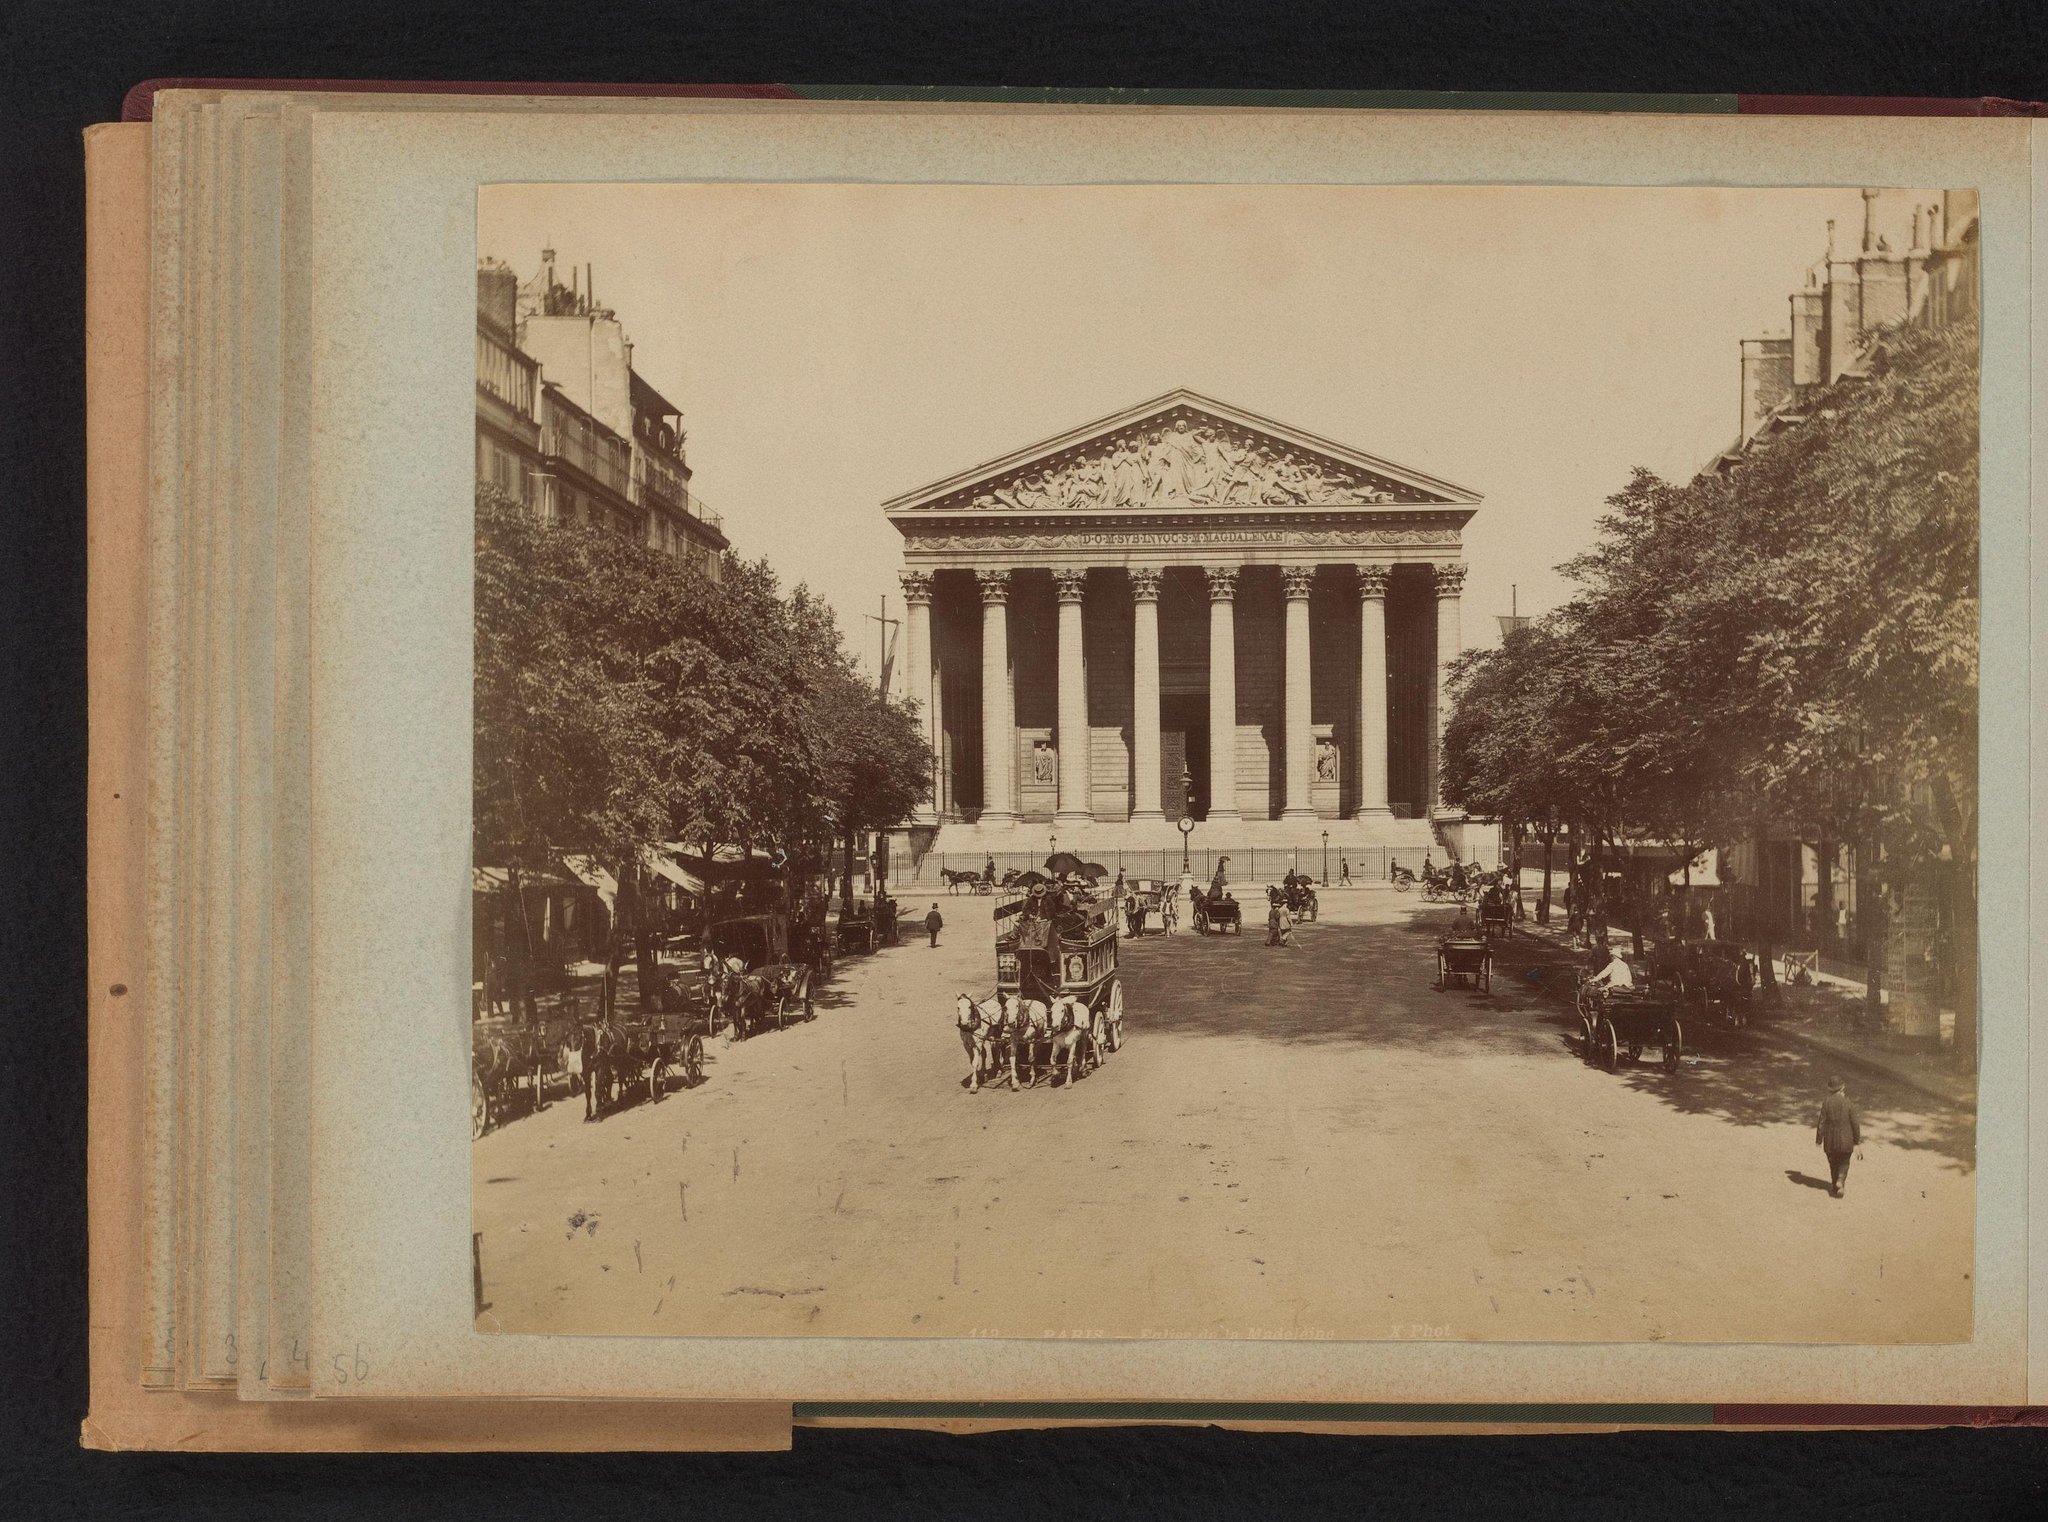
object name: photograph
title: Gezicht op la Madeleine in Parijs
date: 1887-1900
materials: paper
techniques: albumen print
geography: paris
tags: diligence, omnibus, horse-tram, church (exterior), street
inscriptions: number: ‘113’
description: Tussen 1887 en ca. 1900 werkten Neurdein frères onder andere onder de naam 'X phot.'.